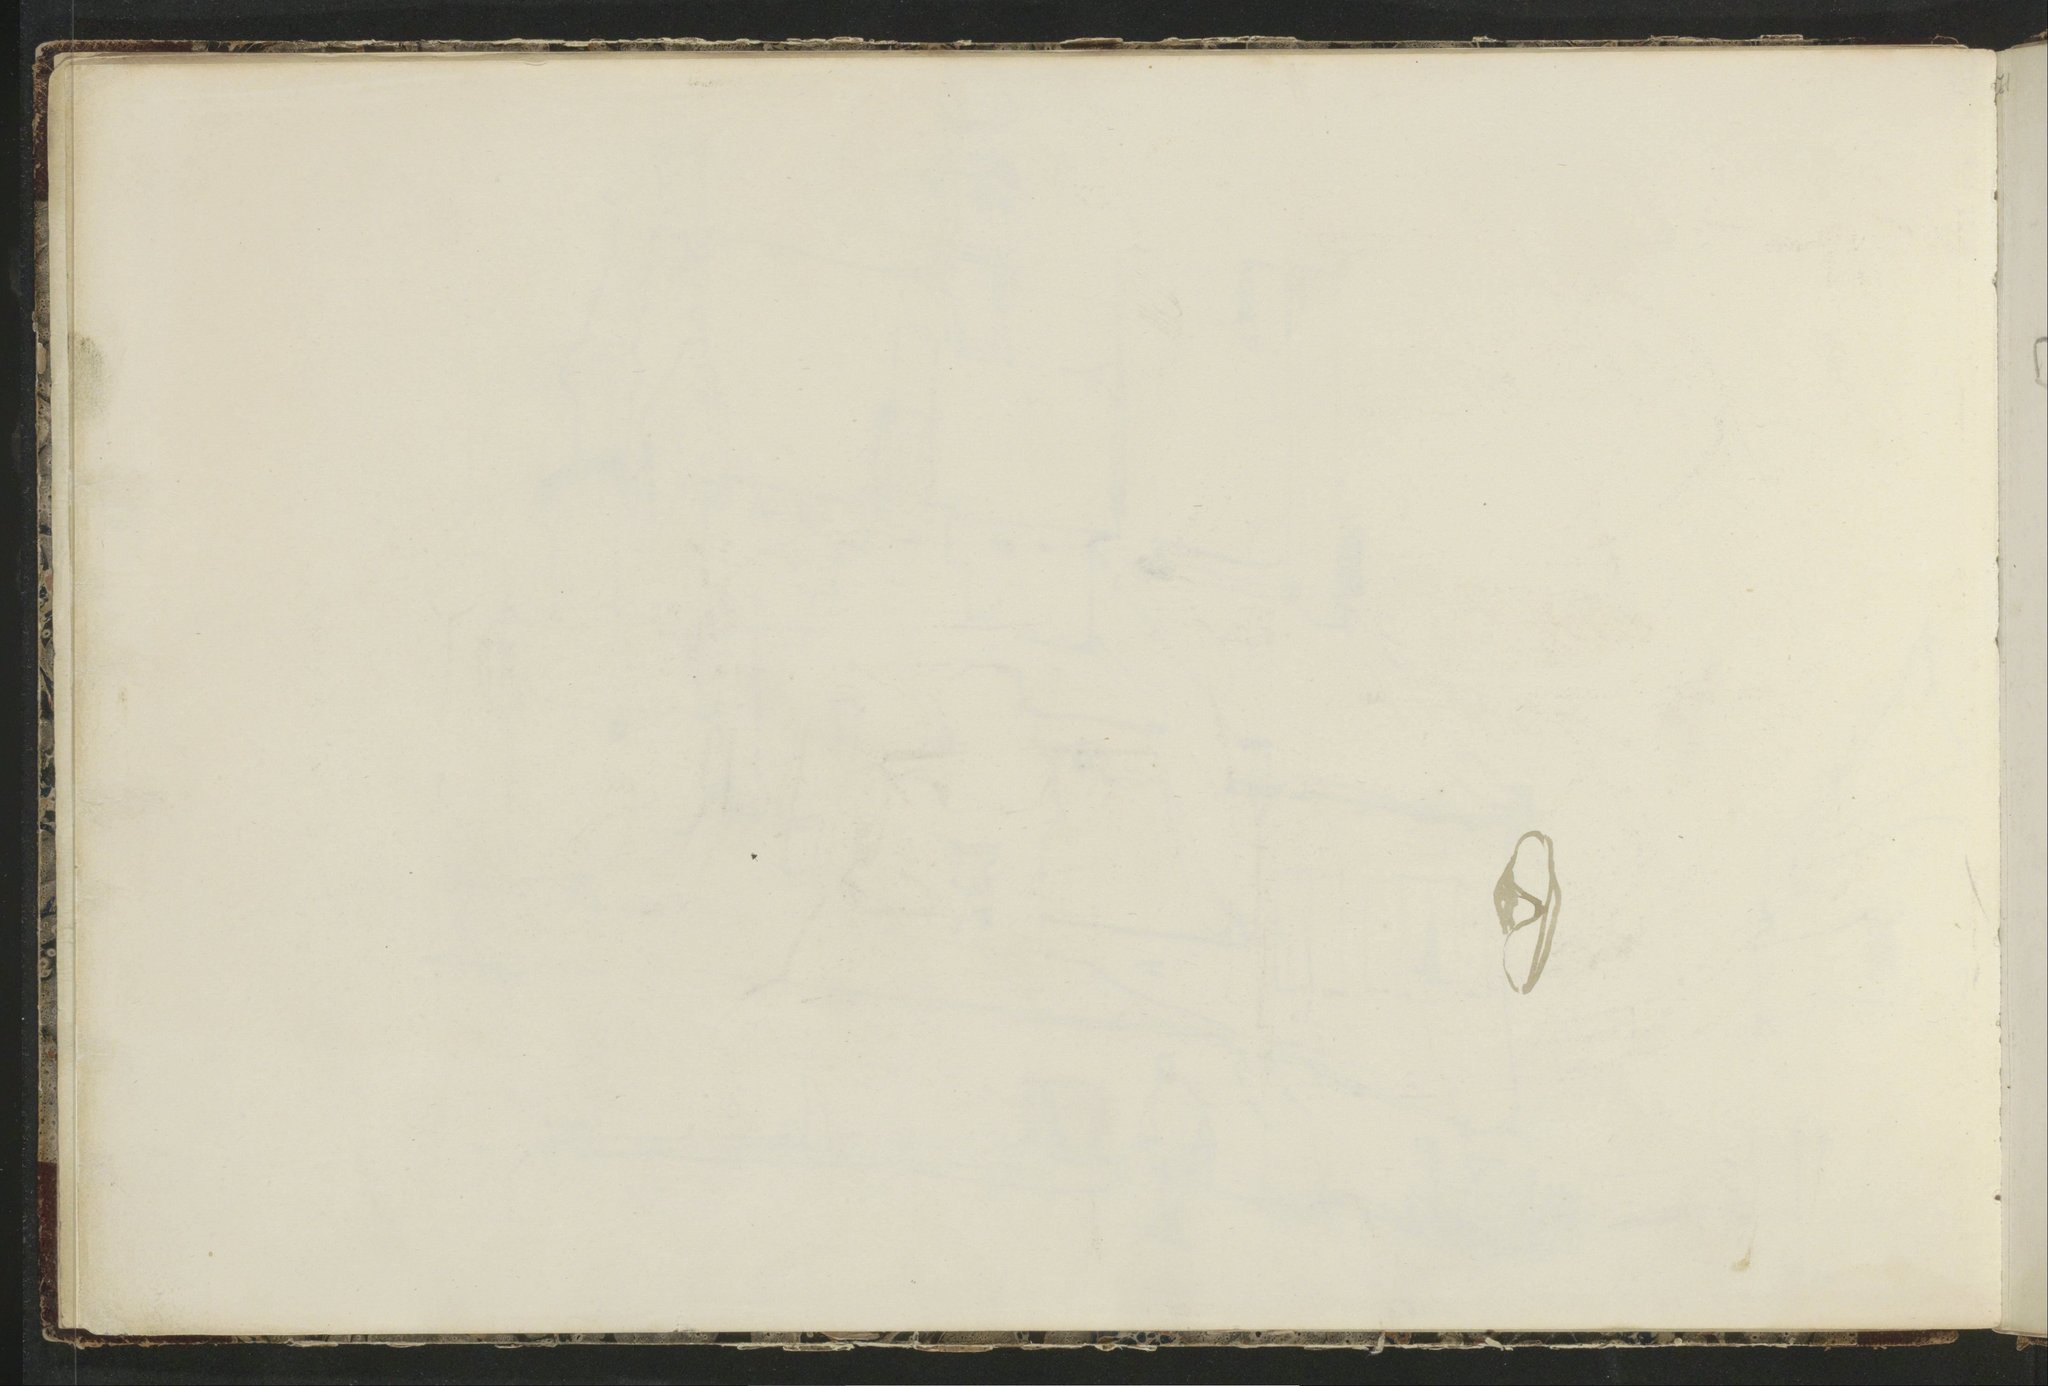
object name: sketchbook leaf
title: Studie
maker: johannes bosboom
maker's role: draughtsman, painter, print maker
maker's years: 1817-1891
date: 1827-1891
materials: paper, watercolor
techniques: brush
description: Blad 2 verso uit een schetsboek met 11 bladen.